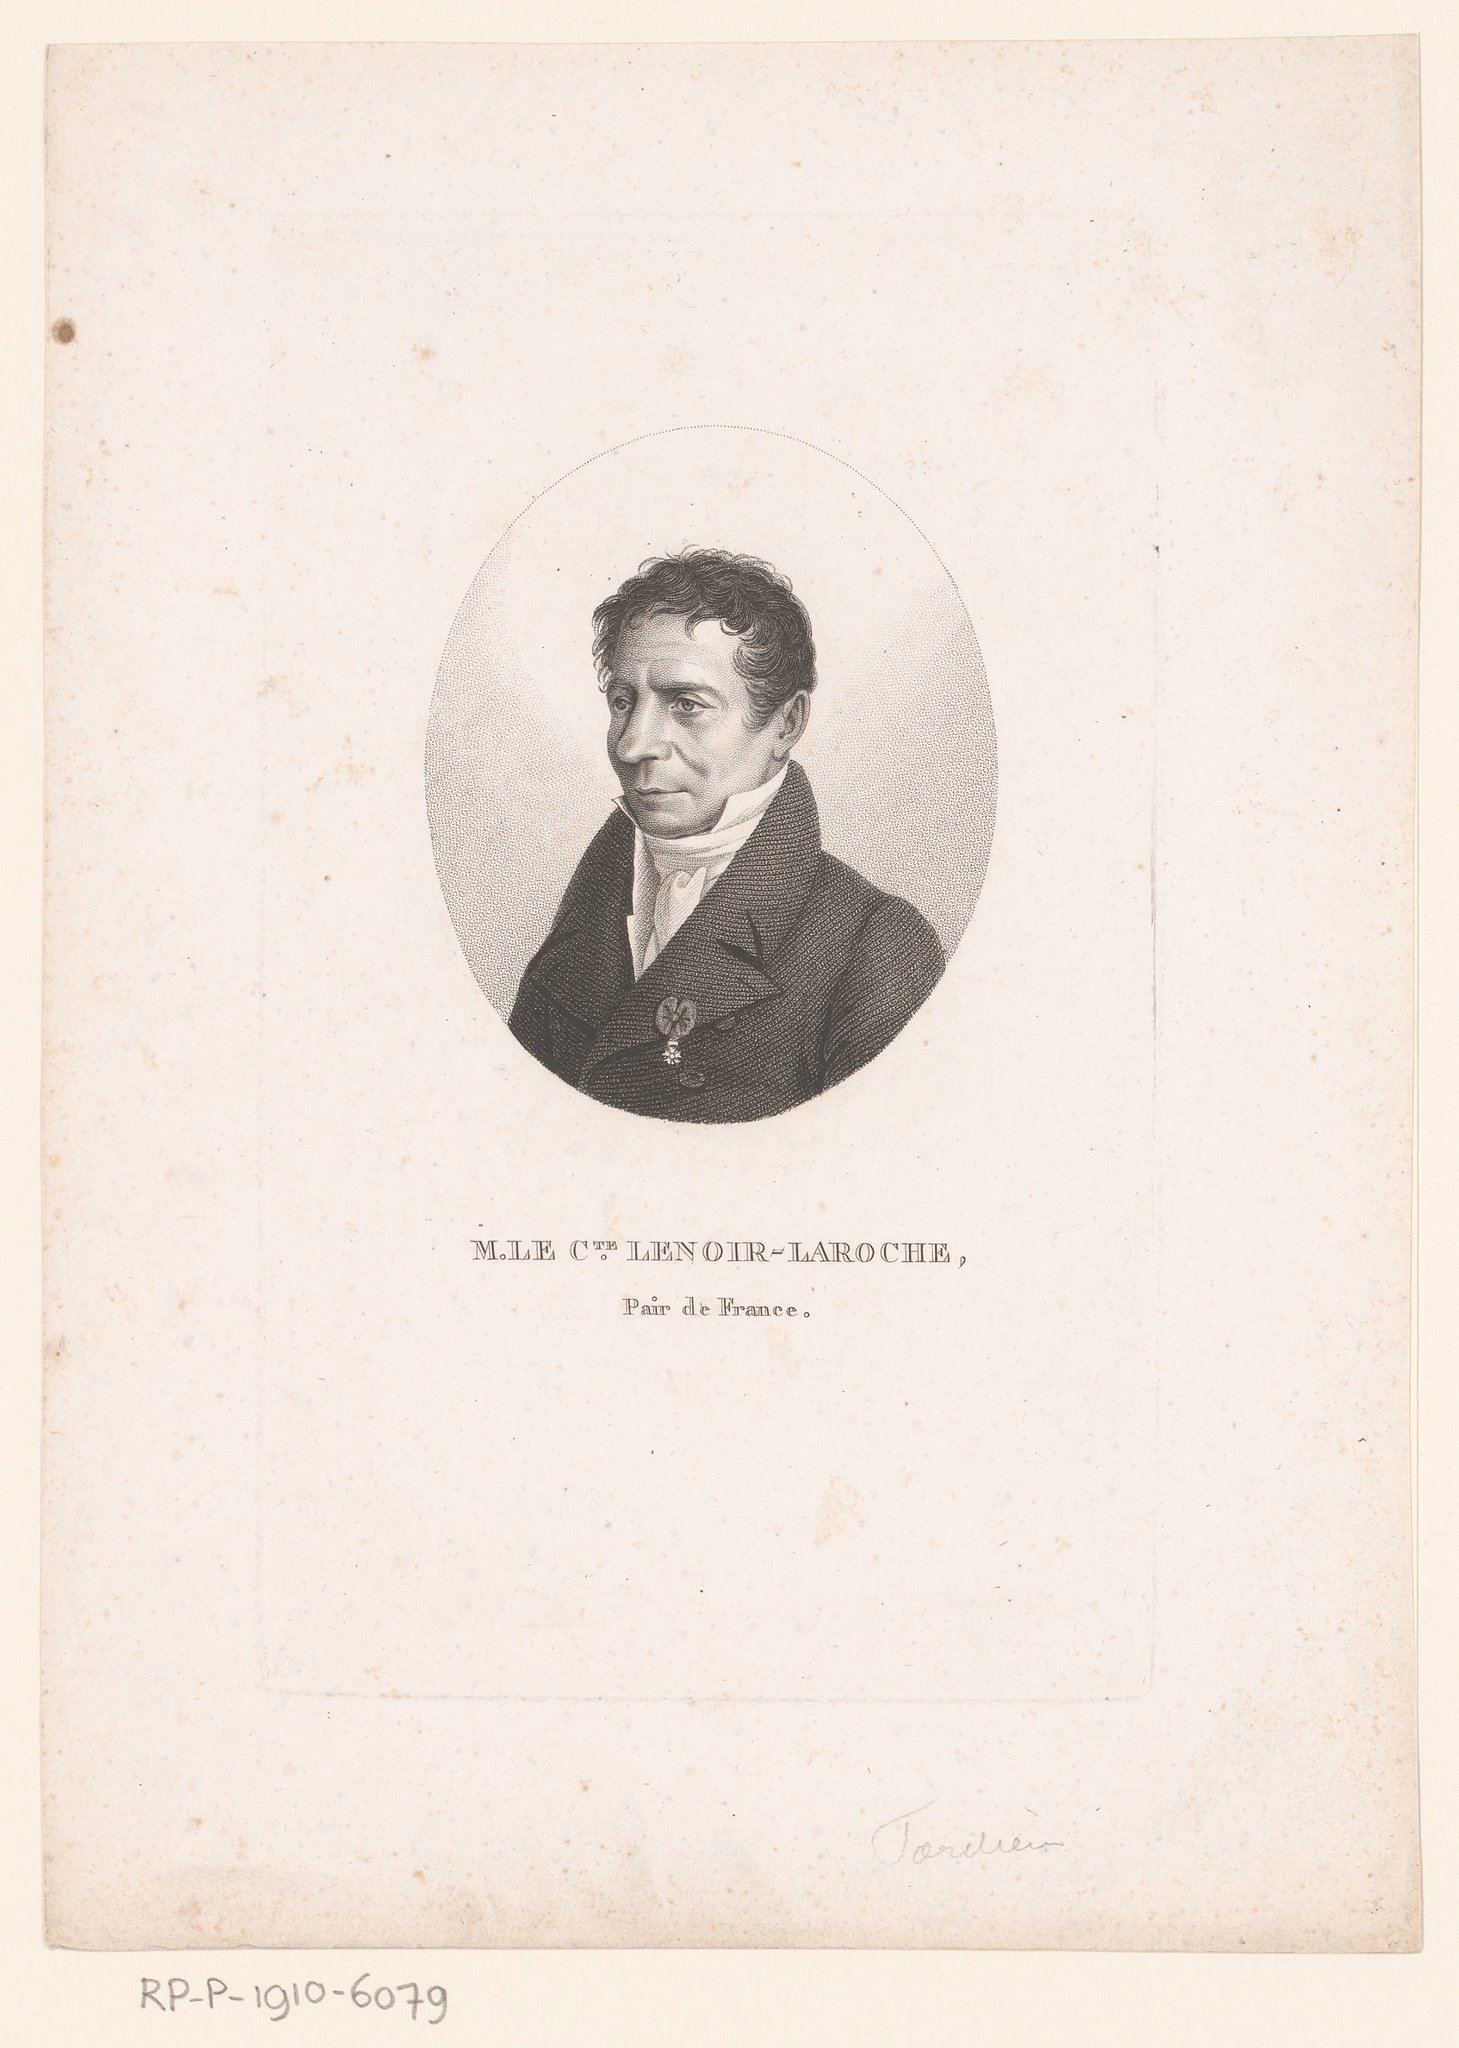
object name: book illustration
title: Portret van Jean-Jacques Lenoir-Laroche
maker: ambroise tardieu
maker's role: print maker, printer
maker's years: 1788-1841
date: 1820-1821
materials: paper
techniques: engraving, roulette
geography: paris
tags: politician, historical persons, politician, e.g. party leader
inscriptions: collector's mark: Lugt 2228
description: Prent uit: Tardieu, Ambroise. Portraits des députés, écrivains et pairs constitutionnels, défenseurs invariables de la charte et de la loi des élections du 5 février 1817. Parijs: Tardieu, Ambroise, 1820-1821.